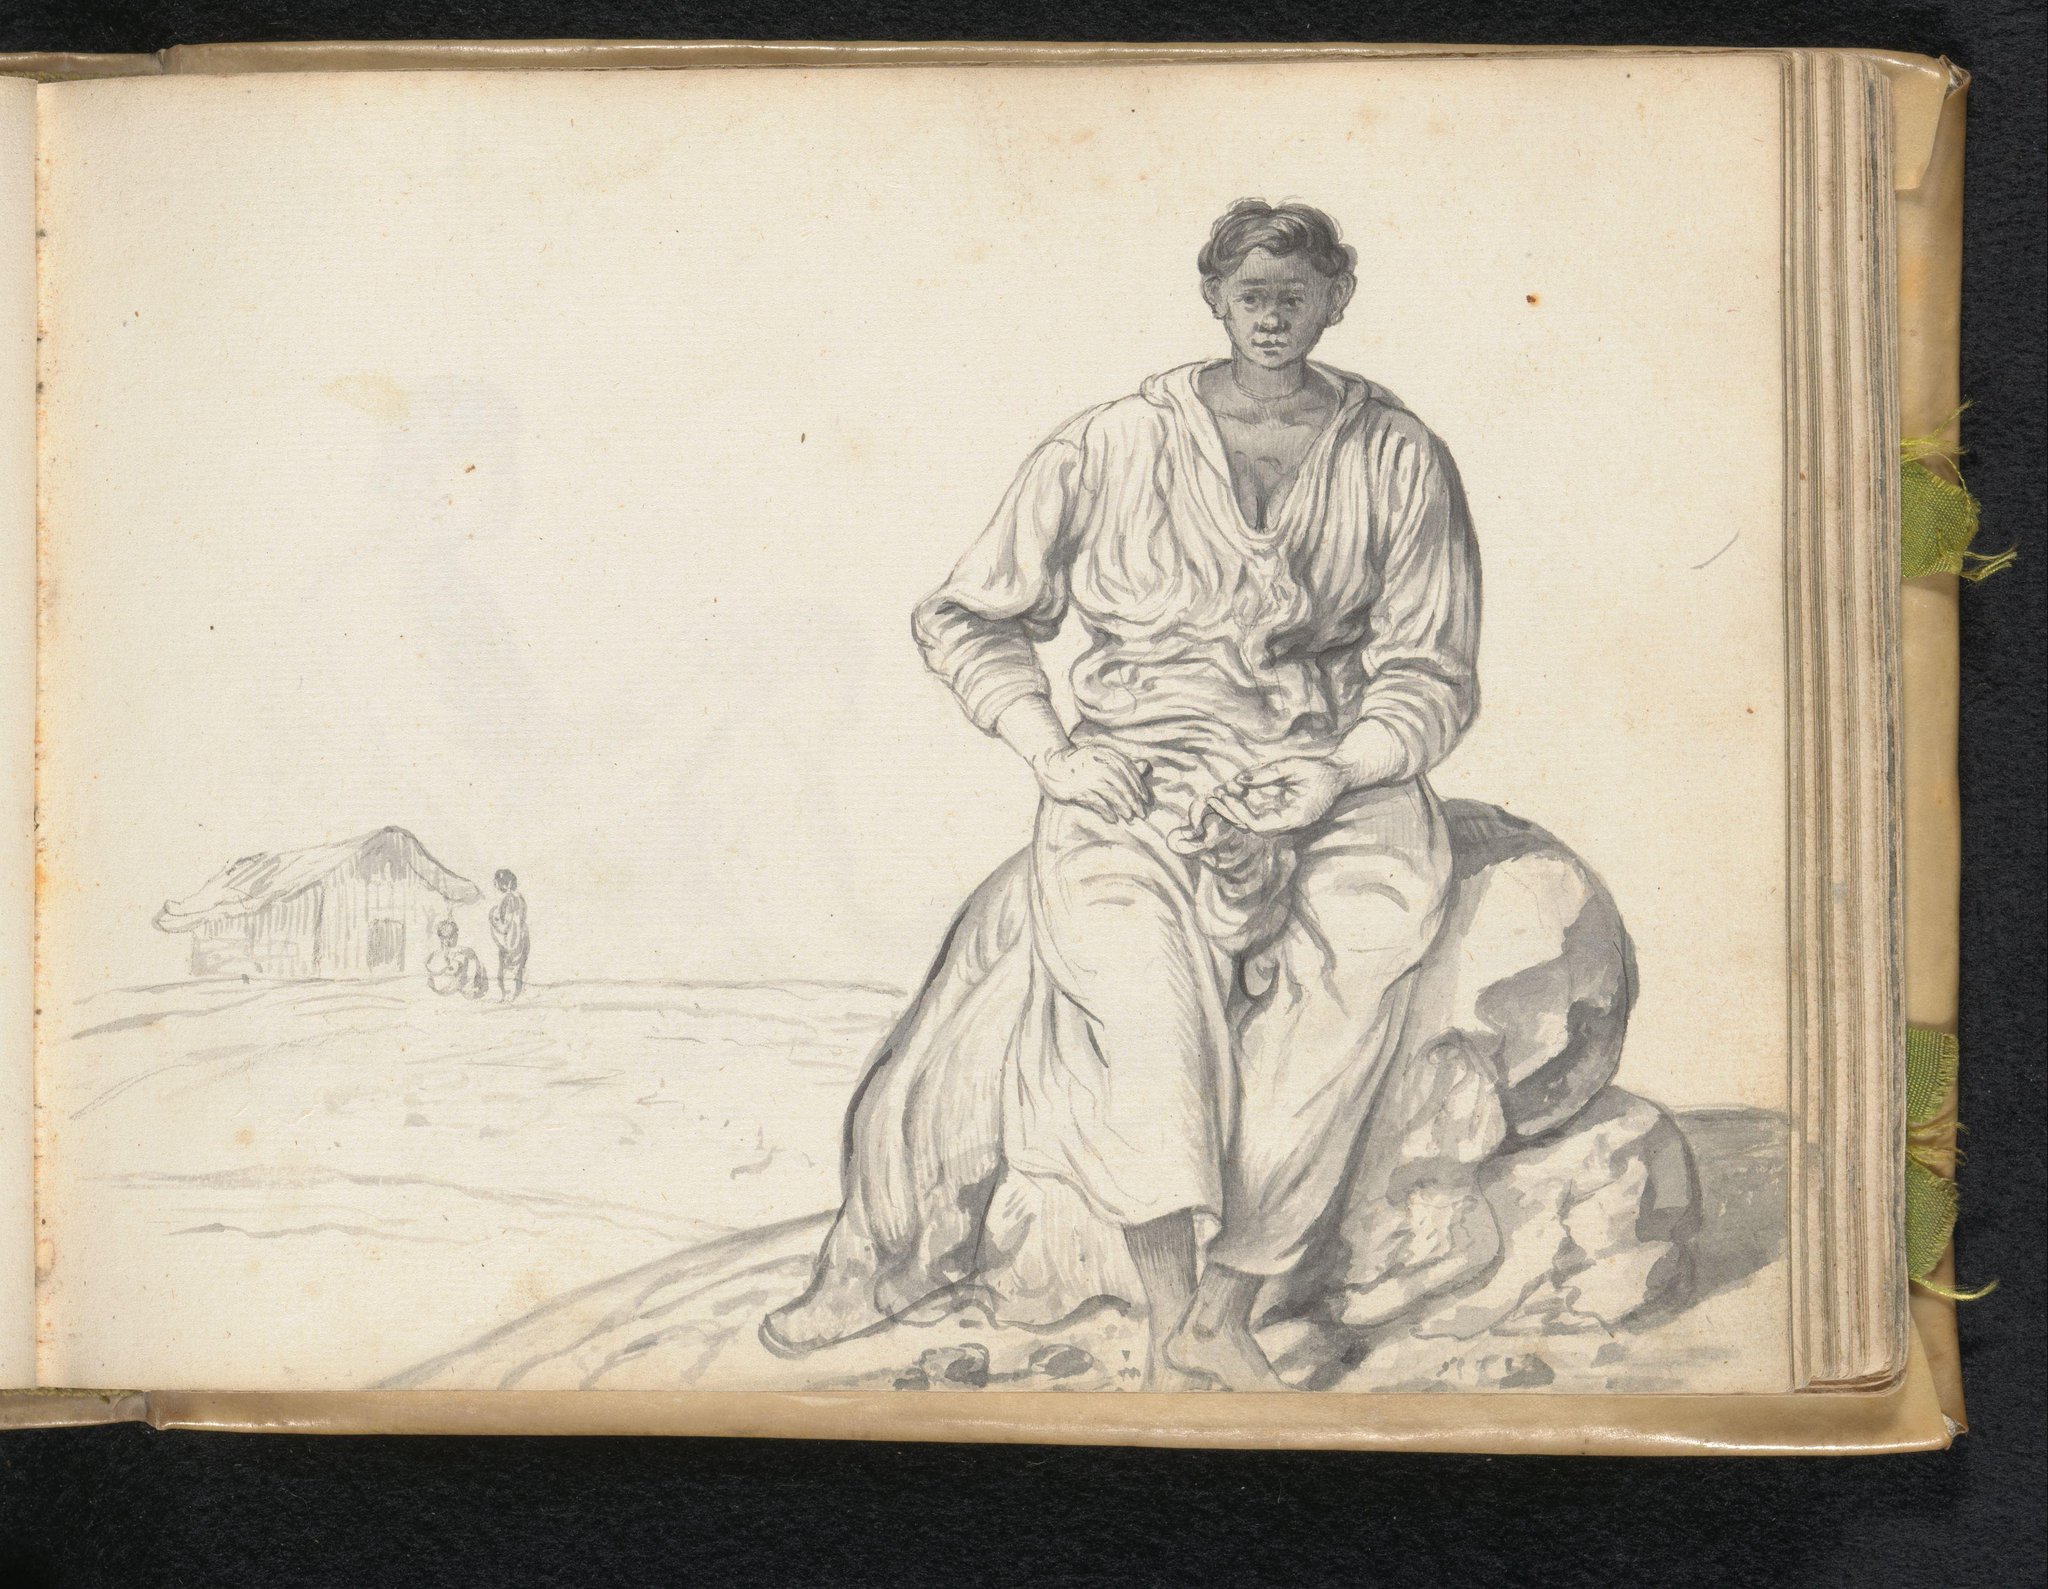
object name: sketchbook leaf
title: Woman sitting on a boulder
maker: esaias boursse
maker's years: 1631-1672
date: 1662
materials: ink, paper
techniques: brush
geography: sri lanka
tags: eurasion, half-caste, skirt (with name), clothing for the upper part of the body (with name), styles of hairdress (with name) - ~women, sri lanka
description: Op een rotsblok zit een Euraziatische vrouw. Ze is gekleed in een lange wikkelrok (redda) en een wijde Portugese bloes met V-hals en lange mouwen (hatte). Het haar is dik en golvend, zonder scheiding in het midden, maar waarschijnlijk toch van achter in een wrong (condé) gebonden. Op haar schoot ligt iets wat lijkt op een geopend zakje. De vingers van haar linkerhand houden iets vast, wellicht een arecanoot. Op achtergrond links is zeer schetsmatig een klein huis getekend met een deuropening; het huis (mati geya) heeft vakwerk-muren van hout met gevlochten tenen en palmblad, gevuld en bestreken met leem (mati), en een ver uitstekend dak van kokospalmblad (cadjan). Ervóór zijn schetsmatig een zittende en een staande figuur getekend. Blad 59 uit een schetsboek met 117 bladen.